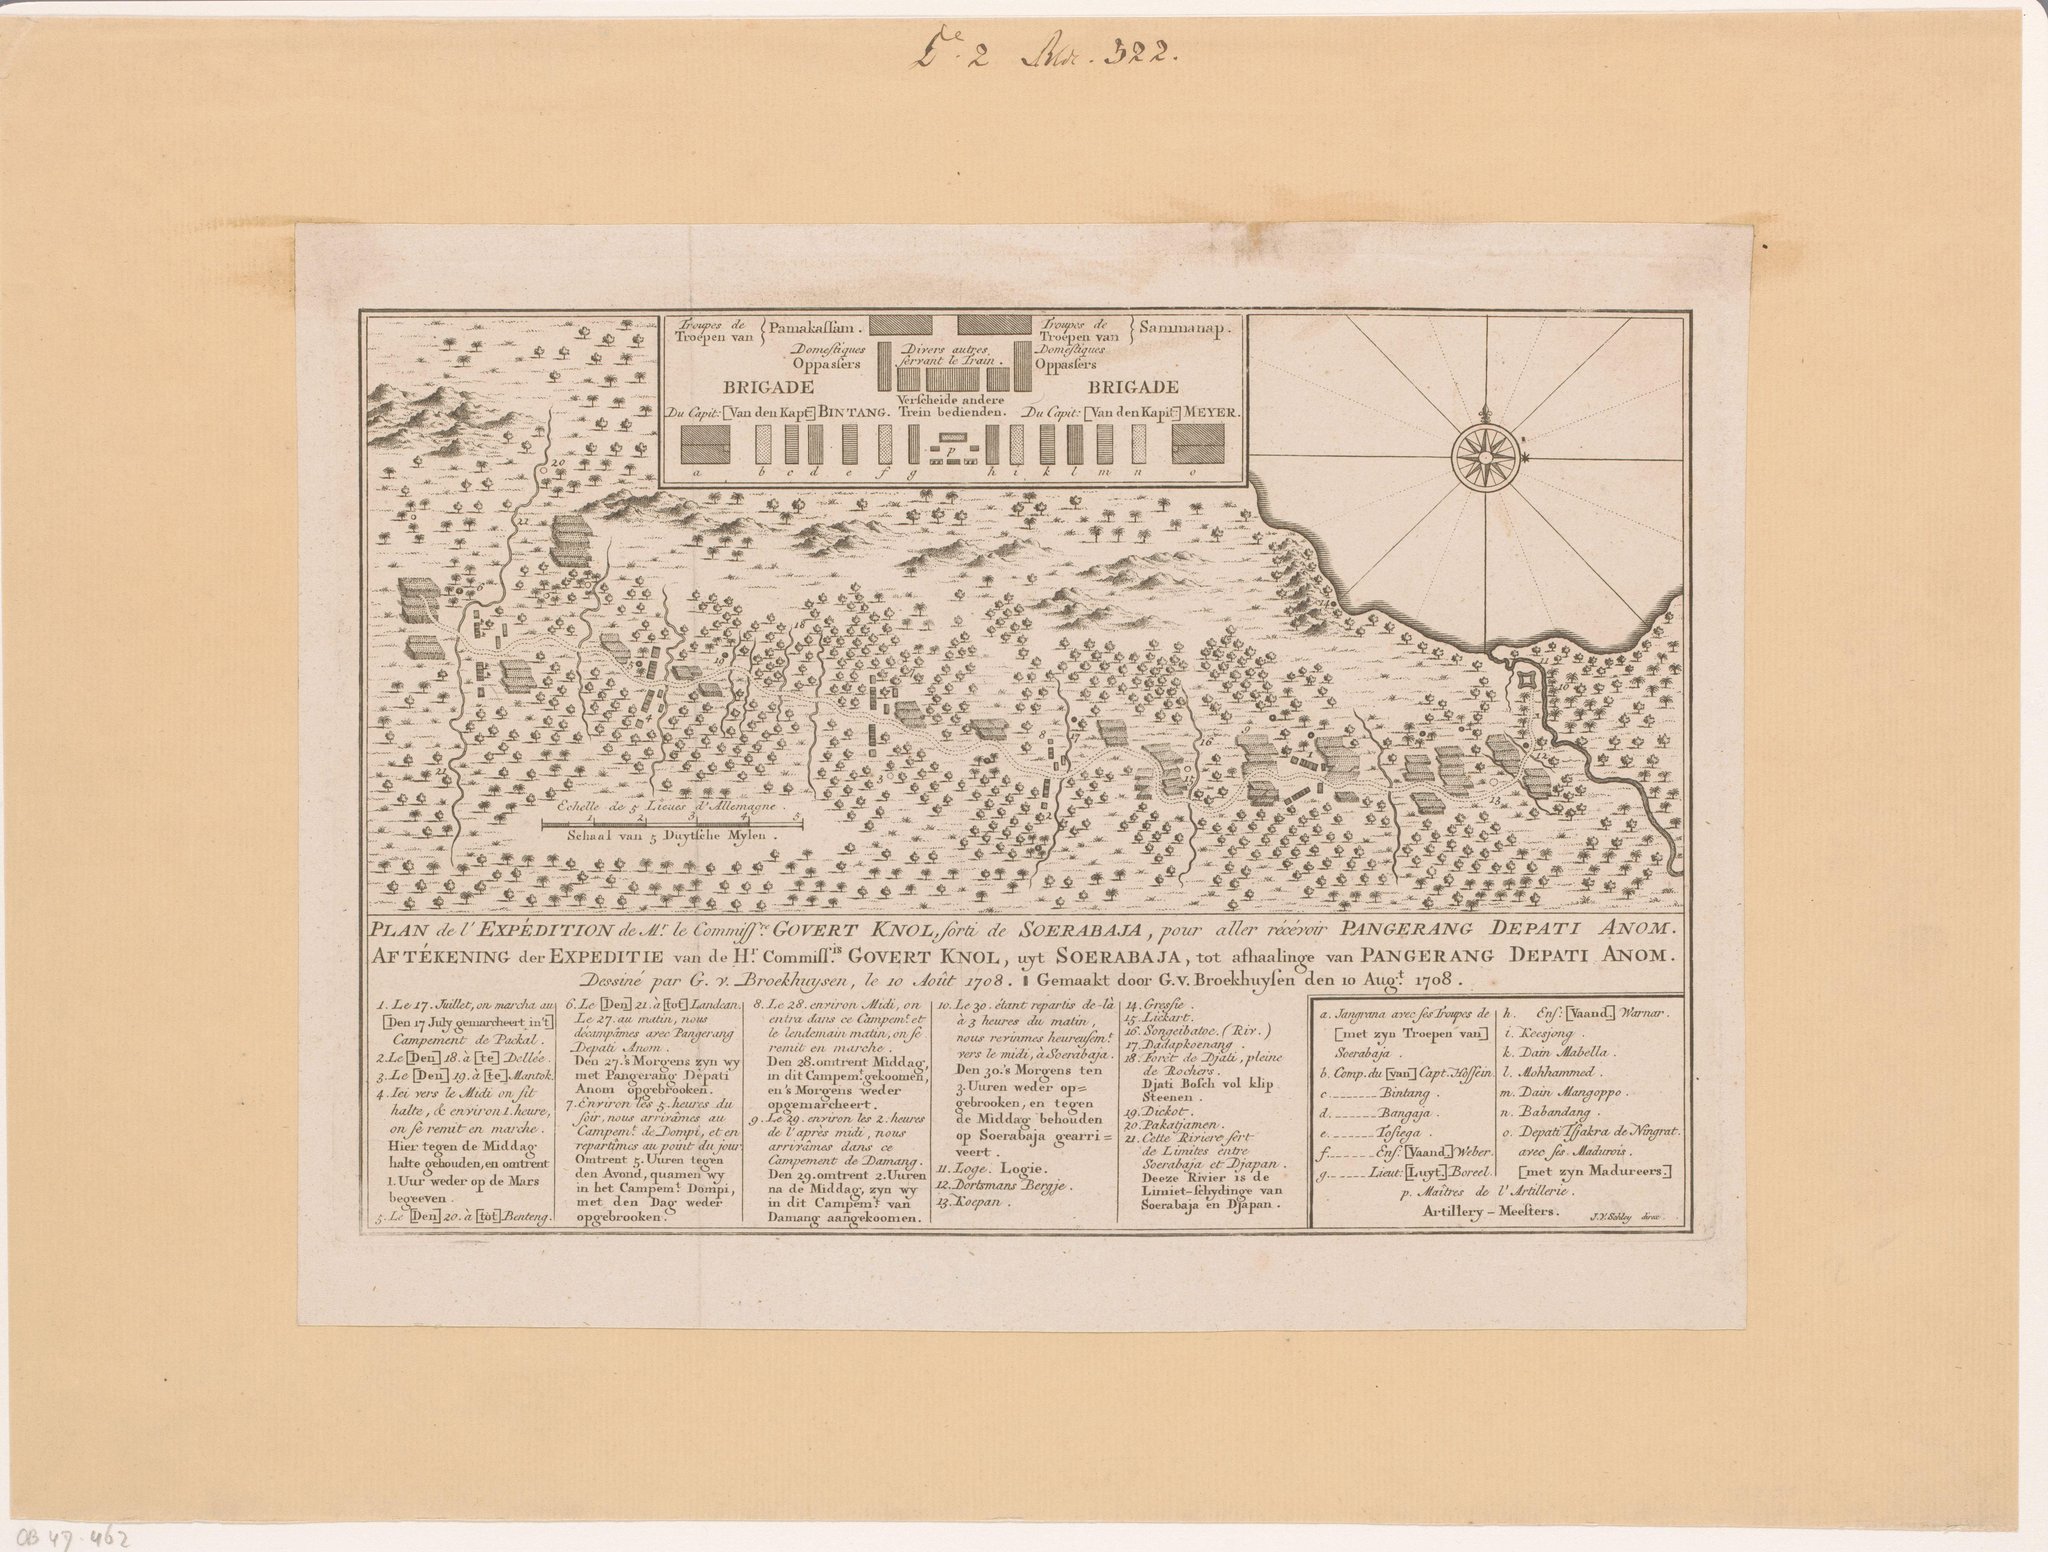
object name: map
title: Plan de l'Expédition de Mr. le Commiss[ai]re Govert Knol (...) / Aftékening der Expeditie van de Hr Commissis Govert Knol, uyt Soerabaja, tot afhaalinge van Pangerang Depati Anom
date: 1765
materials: paper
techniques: engraving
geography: amsterdam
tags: exploration, expedition, voyage of discovery, surabaya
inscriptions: collector's mark: Lugt 2760, collector's mark: Lugt 2228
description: Prent uit: Schley, J. van der. Historische beschryving der reizen (...). 21 dln. Den Haag: Pieter de Hondt (later Amsterdam: J. Roman et al), 1747-1767, dl. 20 (1765), p. 310.